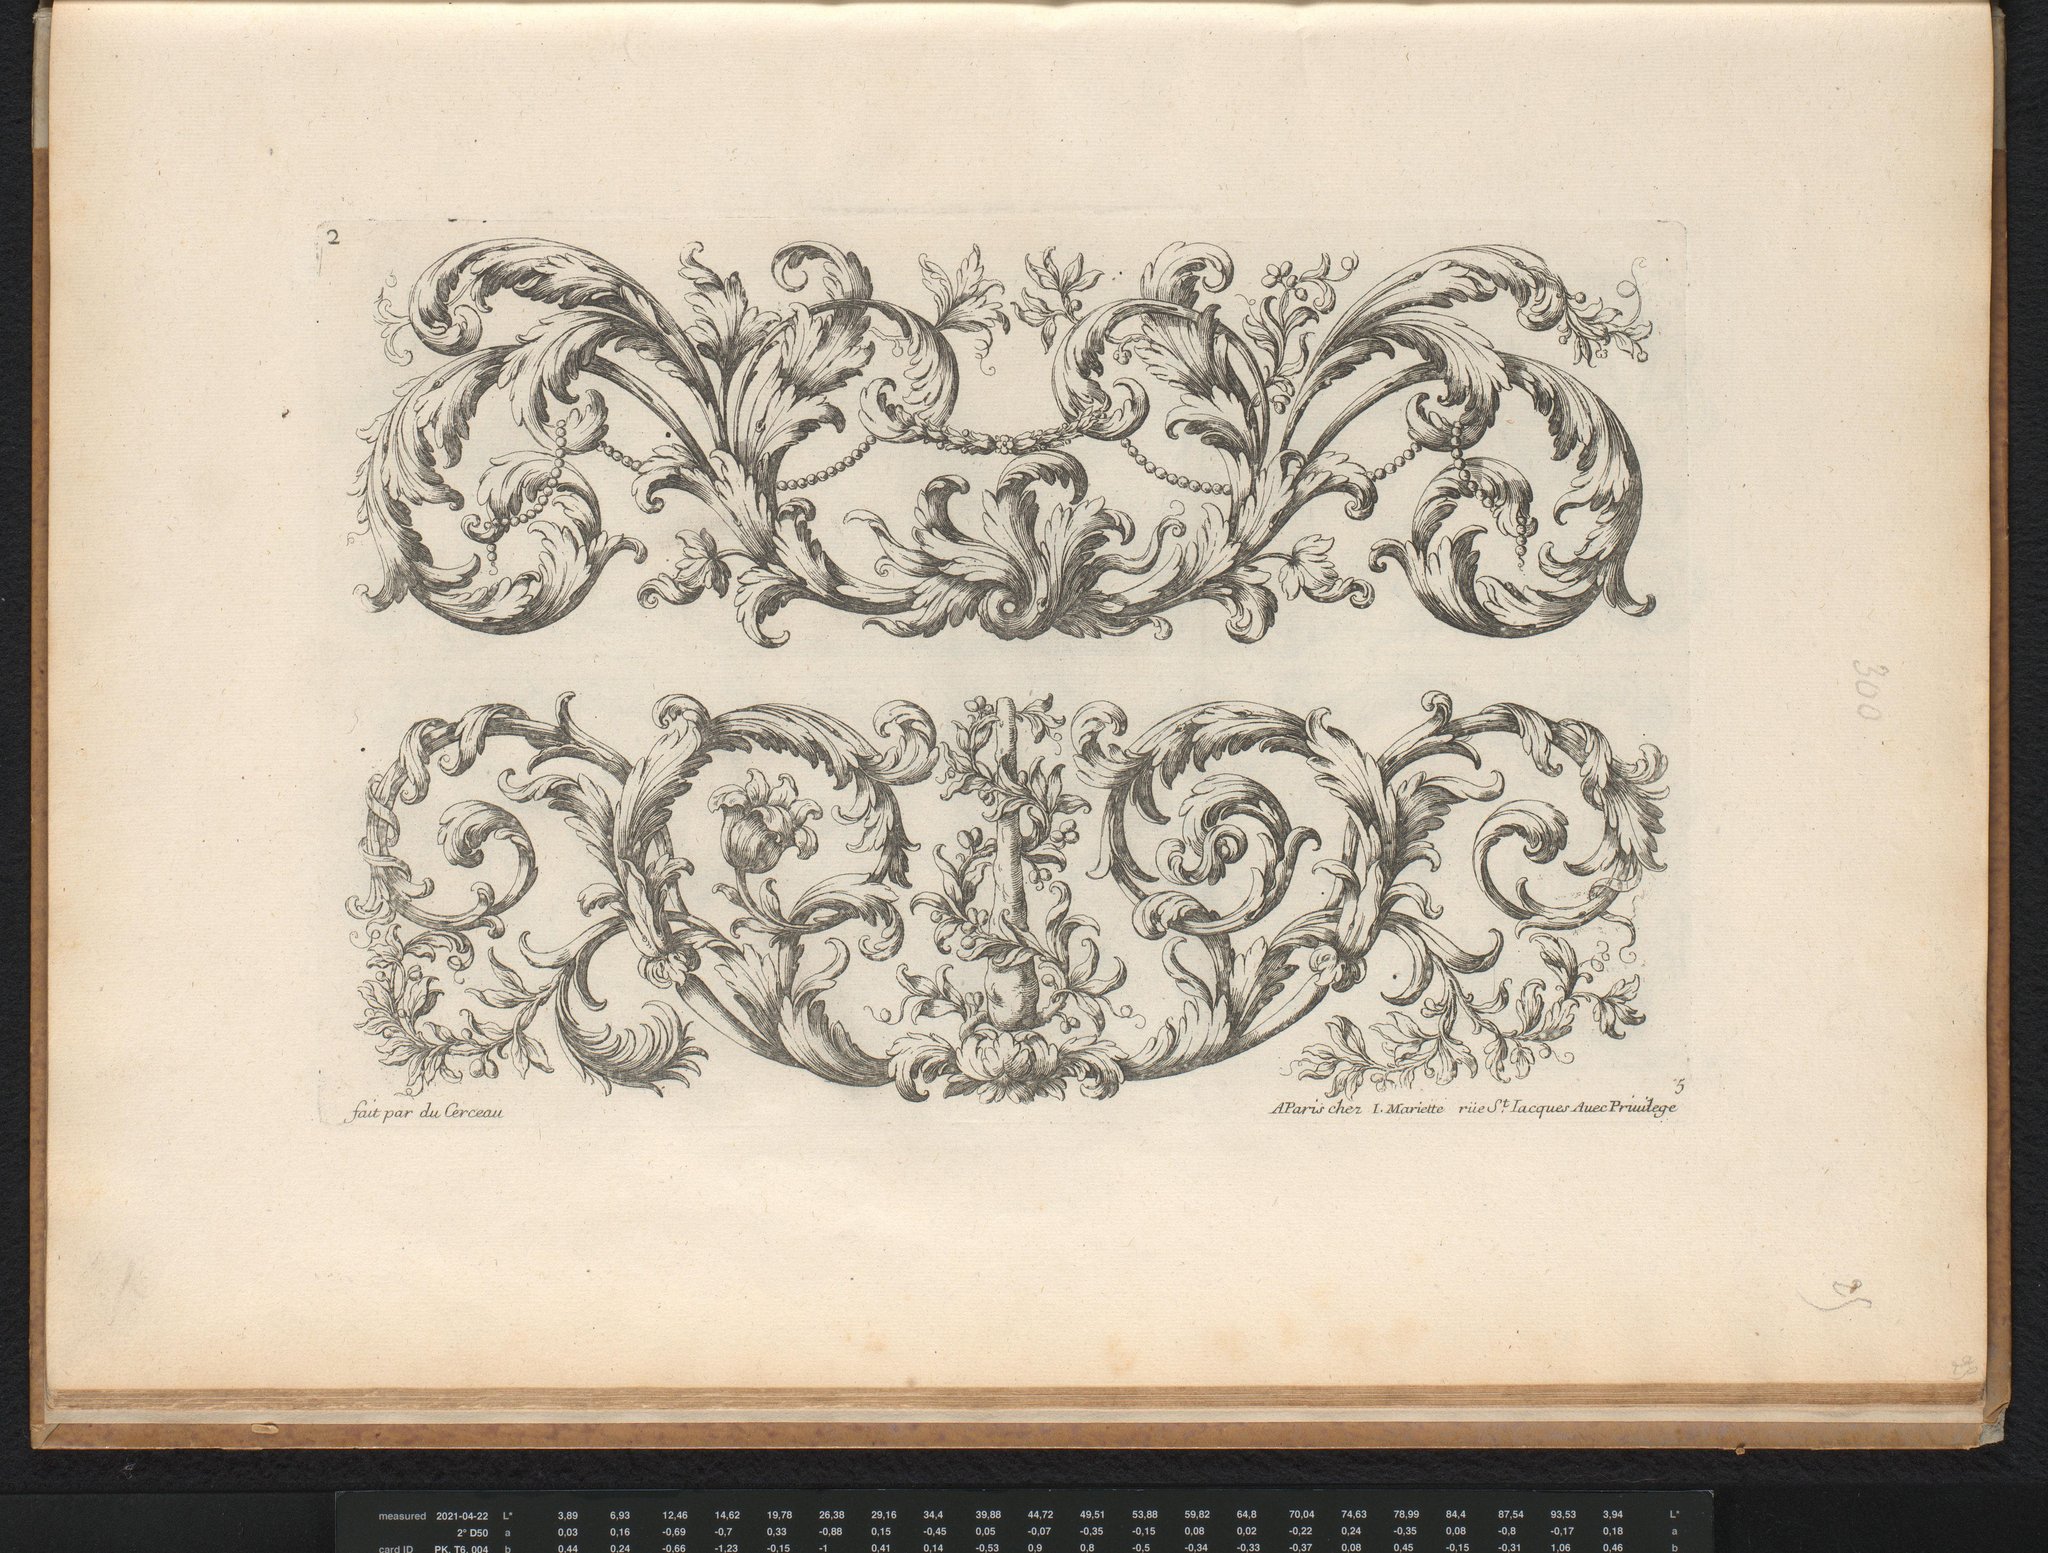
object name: ornament print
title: Frises Propres pour les Peintres, Sculpteurs, Orfèvres &c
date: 1670-1742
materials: paper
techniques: etching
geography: paris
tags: acanthus ~ ornament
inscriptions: collector's mark: Lugt 2760, collector's mark: Lugt 2228a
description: Rechtsonder genummerd: 5. Linksboven genummerd: 2. Deze prent maakt deel uit van een album.